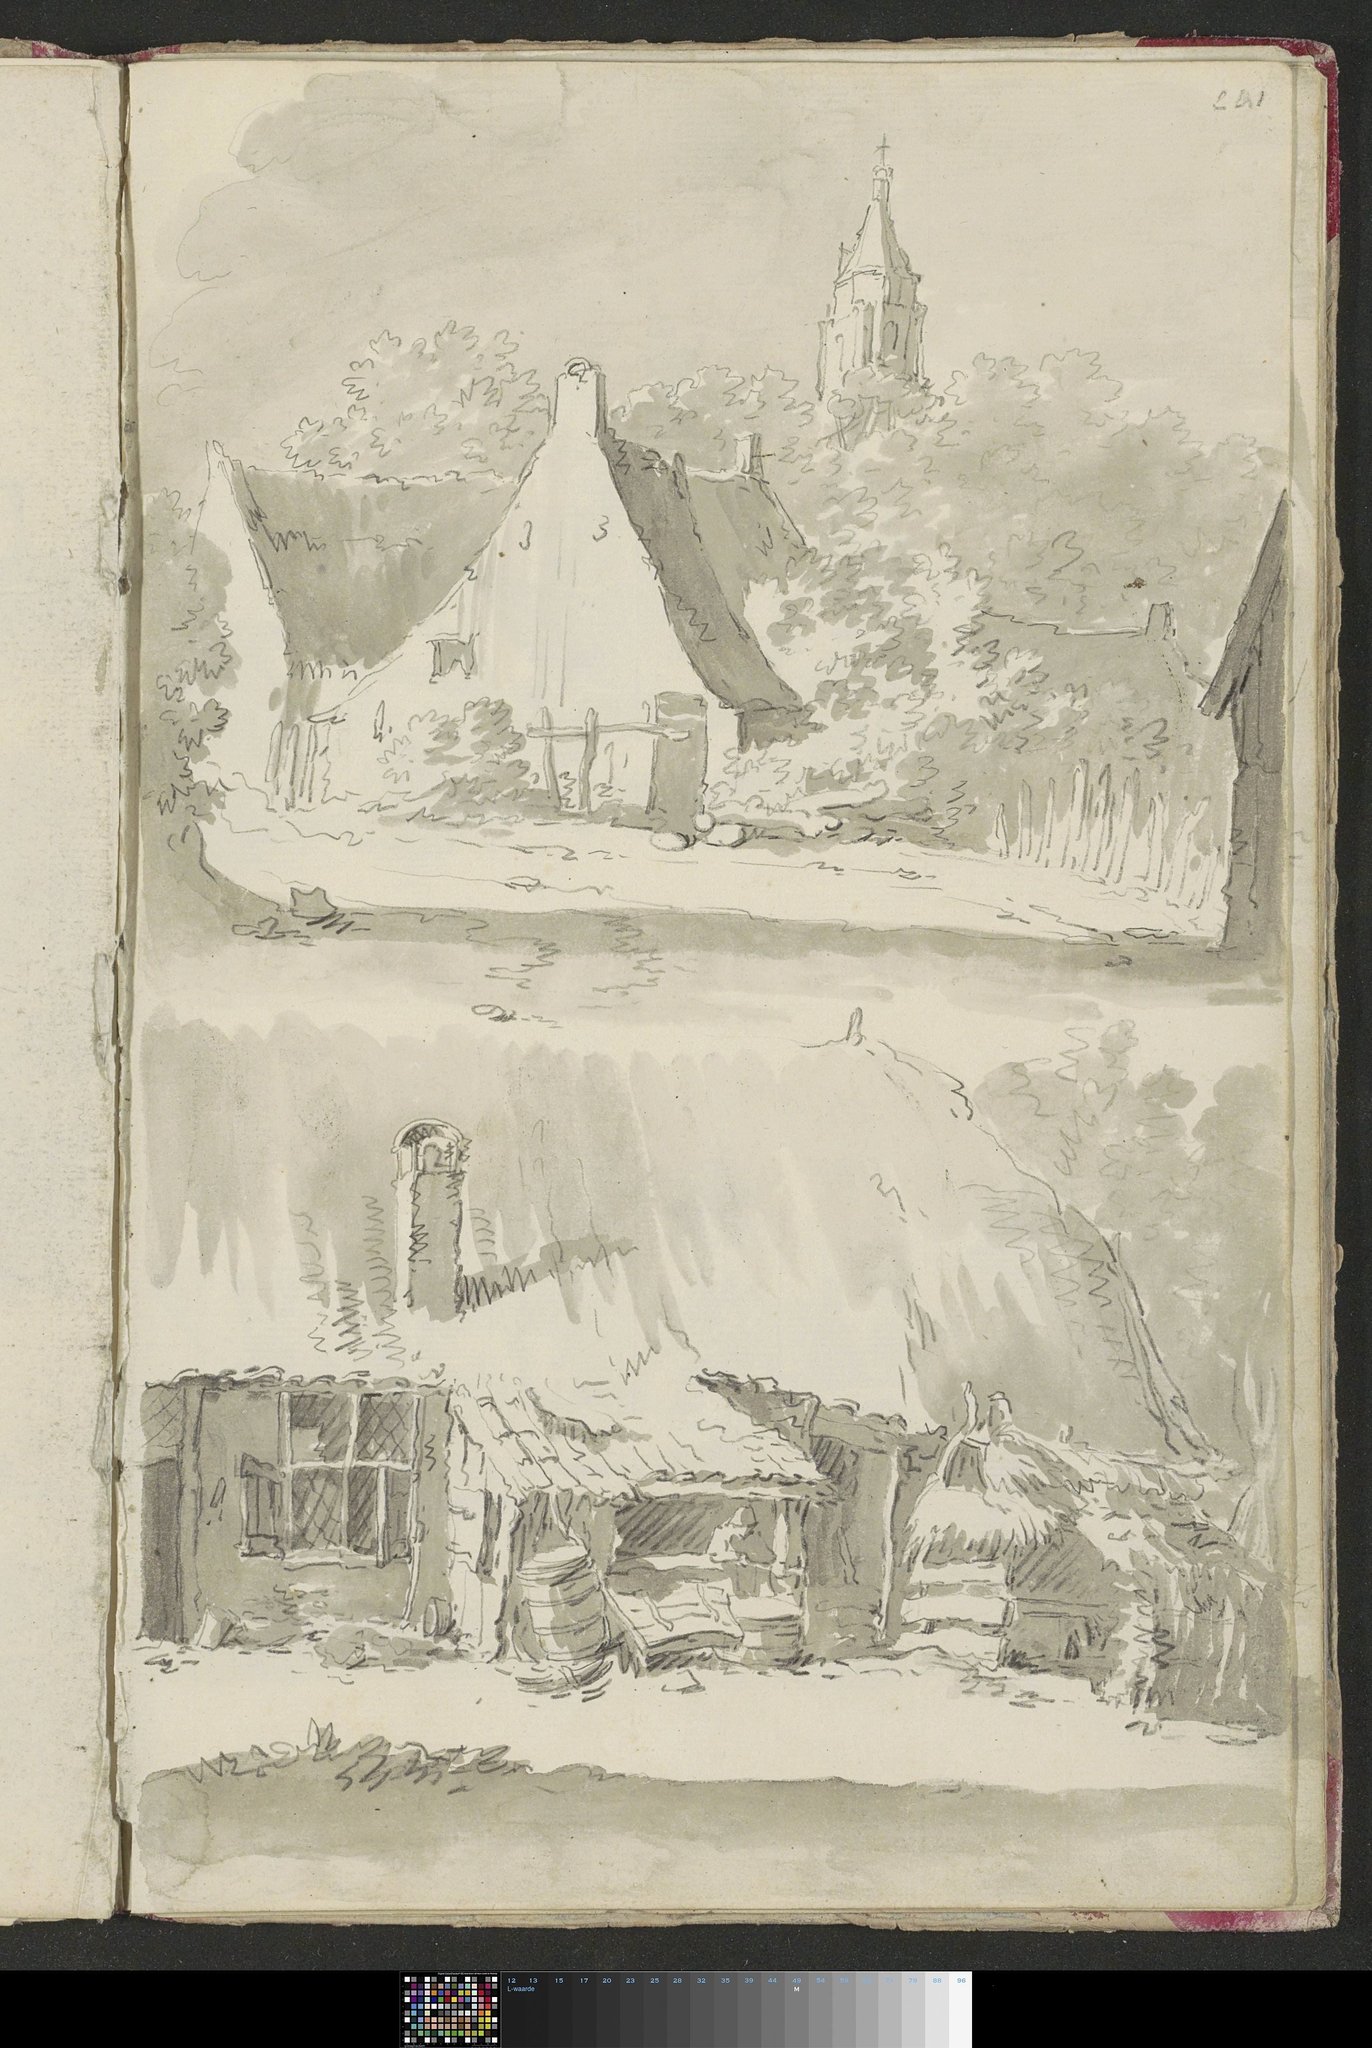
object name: sketchbook leaf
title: Boerderijen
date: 1780-1800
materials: paper, pencil, watercolor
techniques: brush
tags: farm (building)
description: Blad 20 recto uit een schetsboek met 25 bladen.